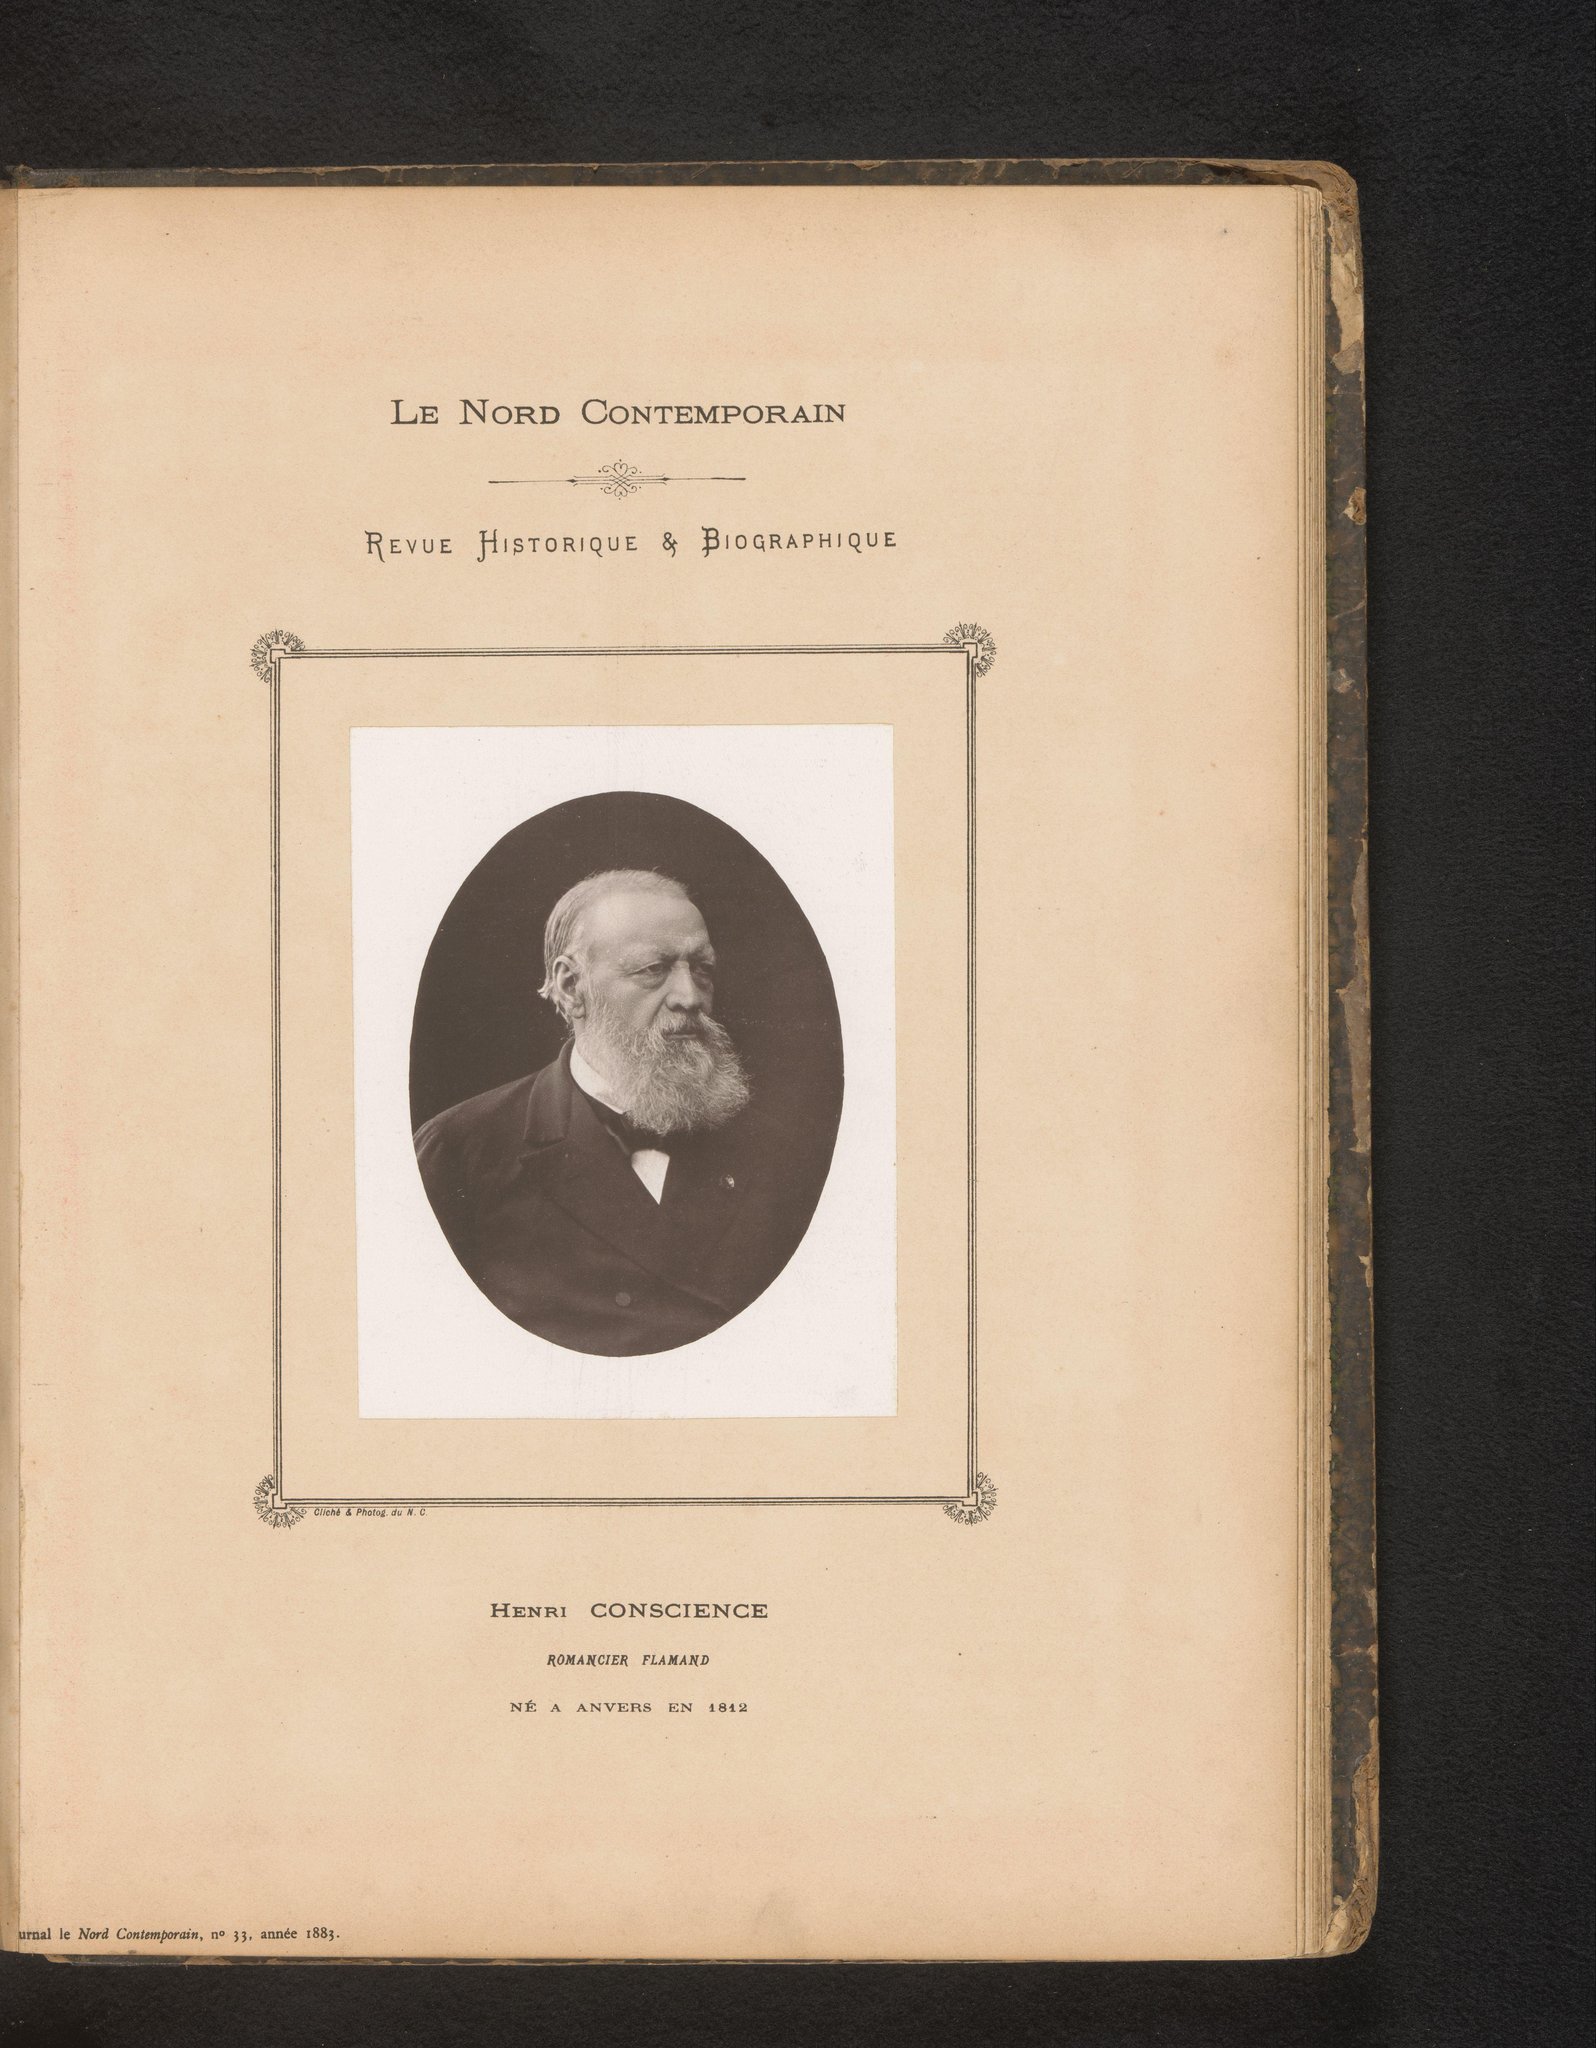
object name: photomechanical print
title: Portret van de schrijver Hendrik Conscience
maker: n.c.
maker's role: fotograaf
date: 1878-1883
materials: paper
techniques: photograph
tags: historical persons, portrait of a writer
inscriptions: inscription: ‘Né a Anvers en 1812’, inscription: ‘[Jo]urnal le Nord Contemporain, No 33, année 1883.’, inscription: ‘Le Nord Contemporain/ Revue Historique & Biographique’